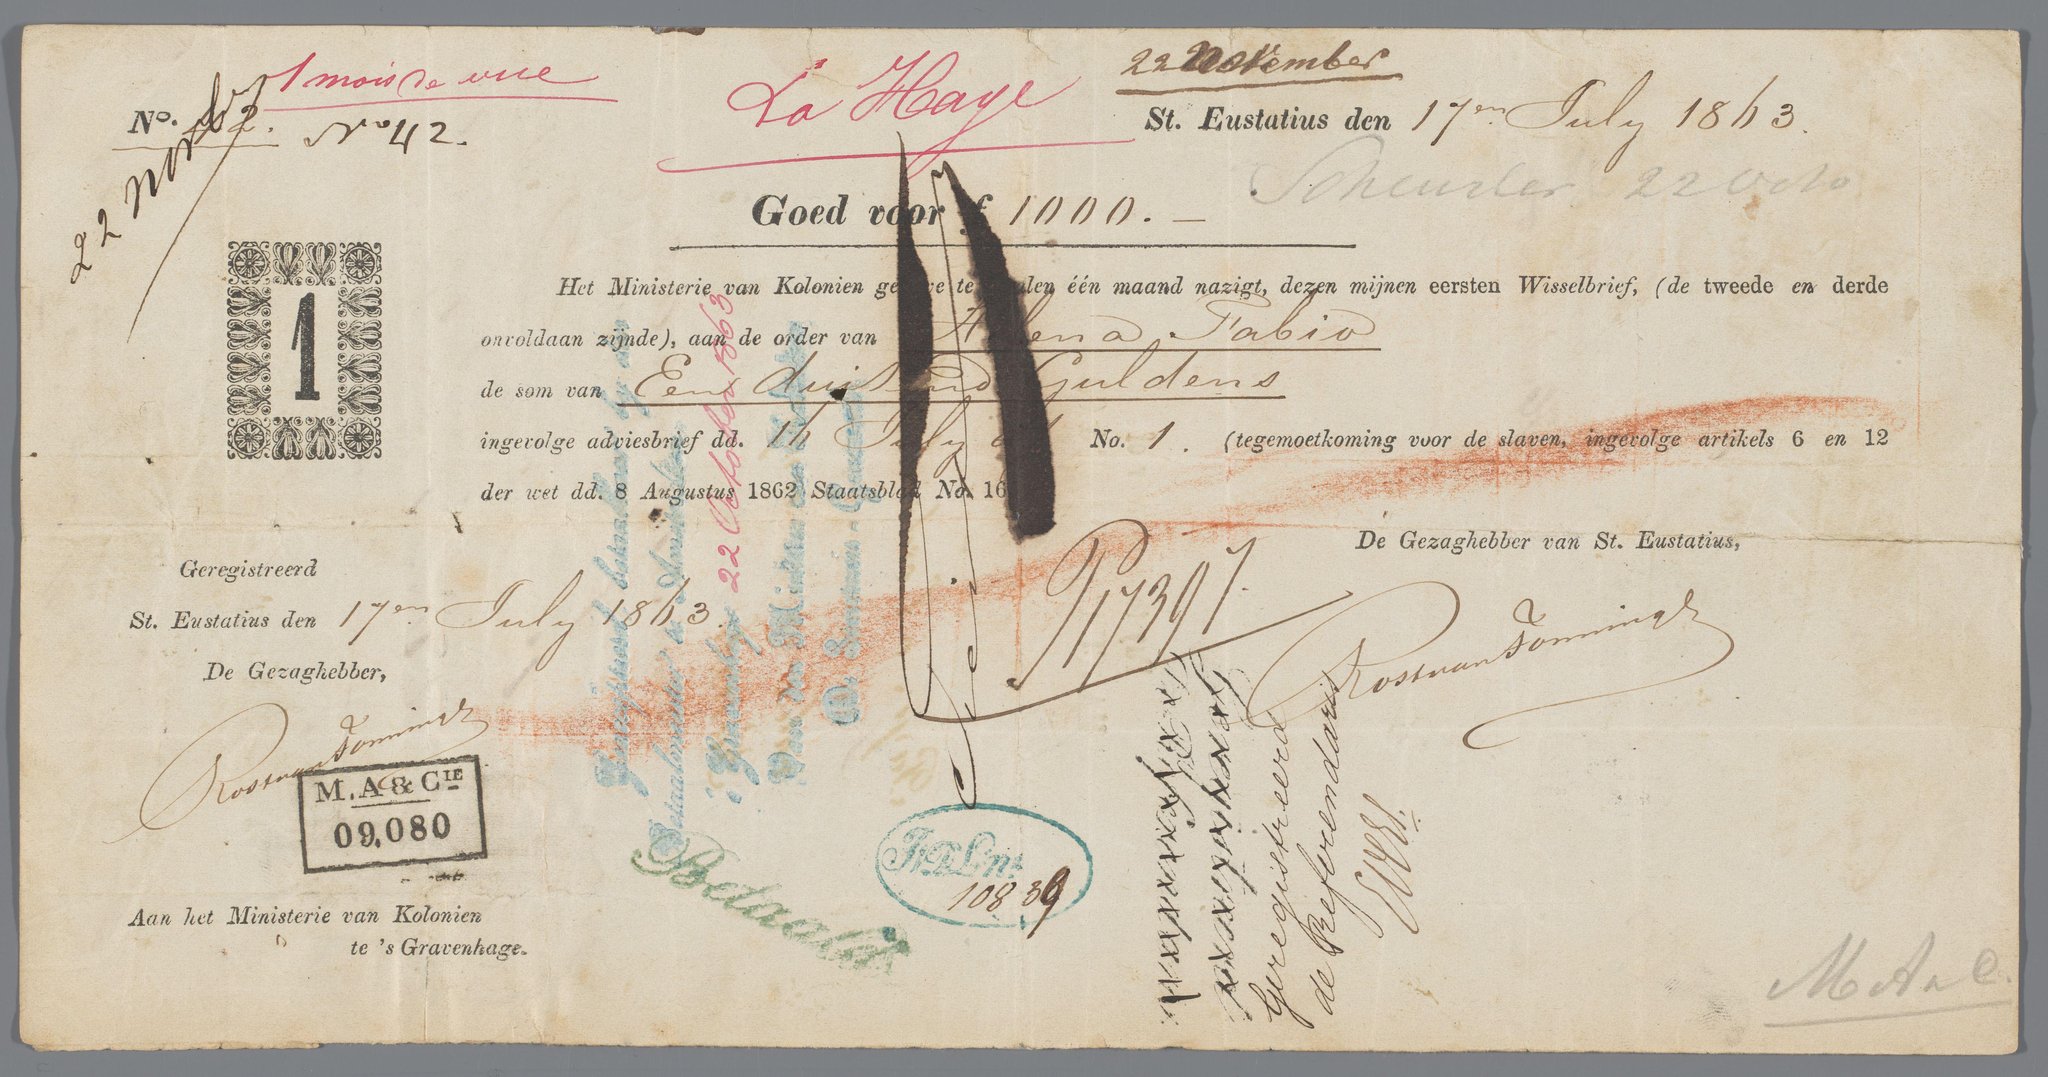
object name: ontvangstbewijs, kwitantie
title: Wisselbrief voor Helena Fabio, slaveneigenaar op Sint Eustatius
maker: Anonymous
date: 1863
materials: ink, paper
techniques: printing, writing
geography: netherlands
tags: slavery; serfs and enslaved persons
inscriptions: date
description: Wisselbrief ter waarde van 1000 gulden ten name van Helena Fabio, 17 juli 1863. Wisselbrief uitgegeven aan slavenhouders op Sint Eustatius om deze bij de Emancipatie van 1863 te compenseren voor het vrij verklaren van de tot slaaf gemaakte mensen die zij tot hun bezit rekenden.